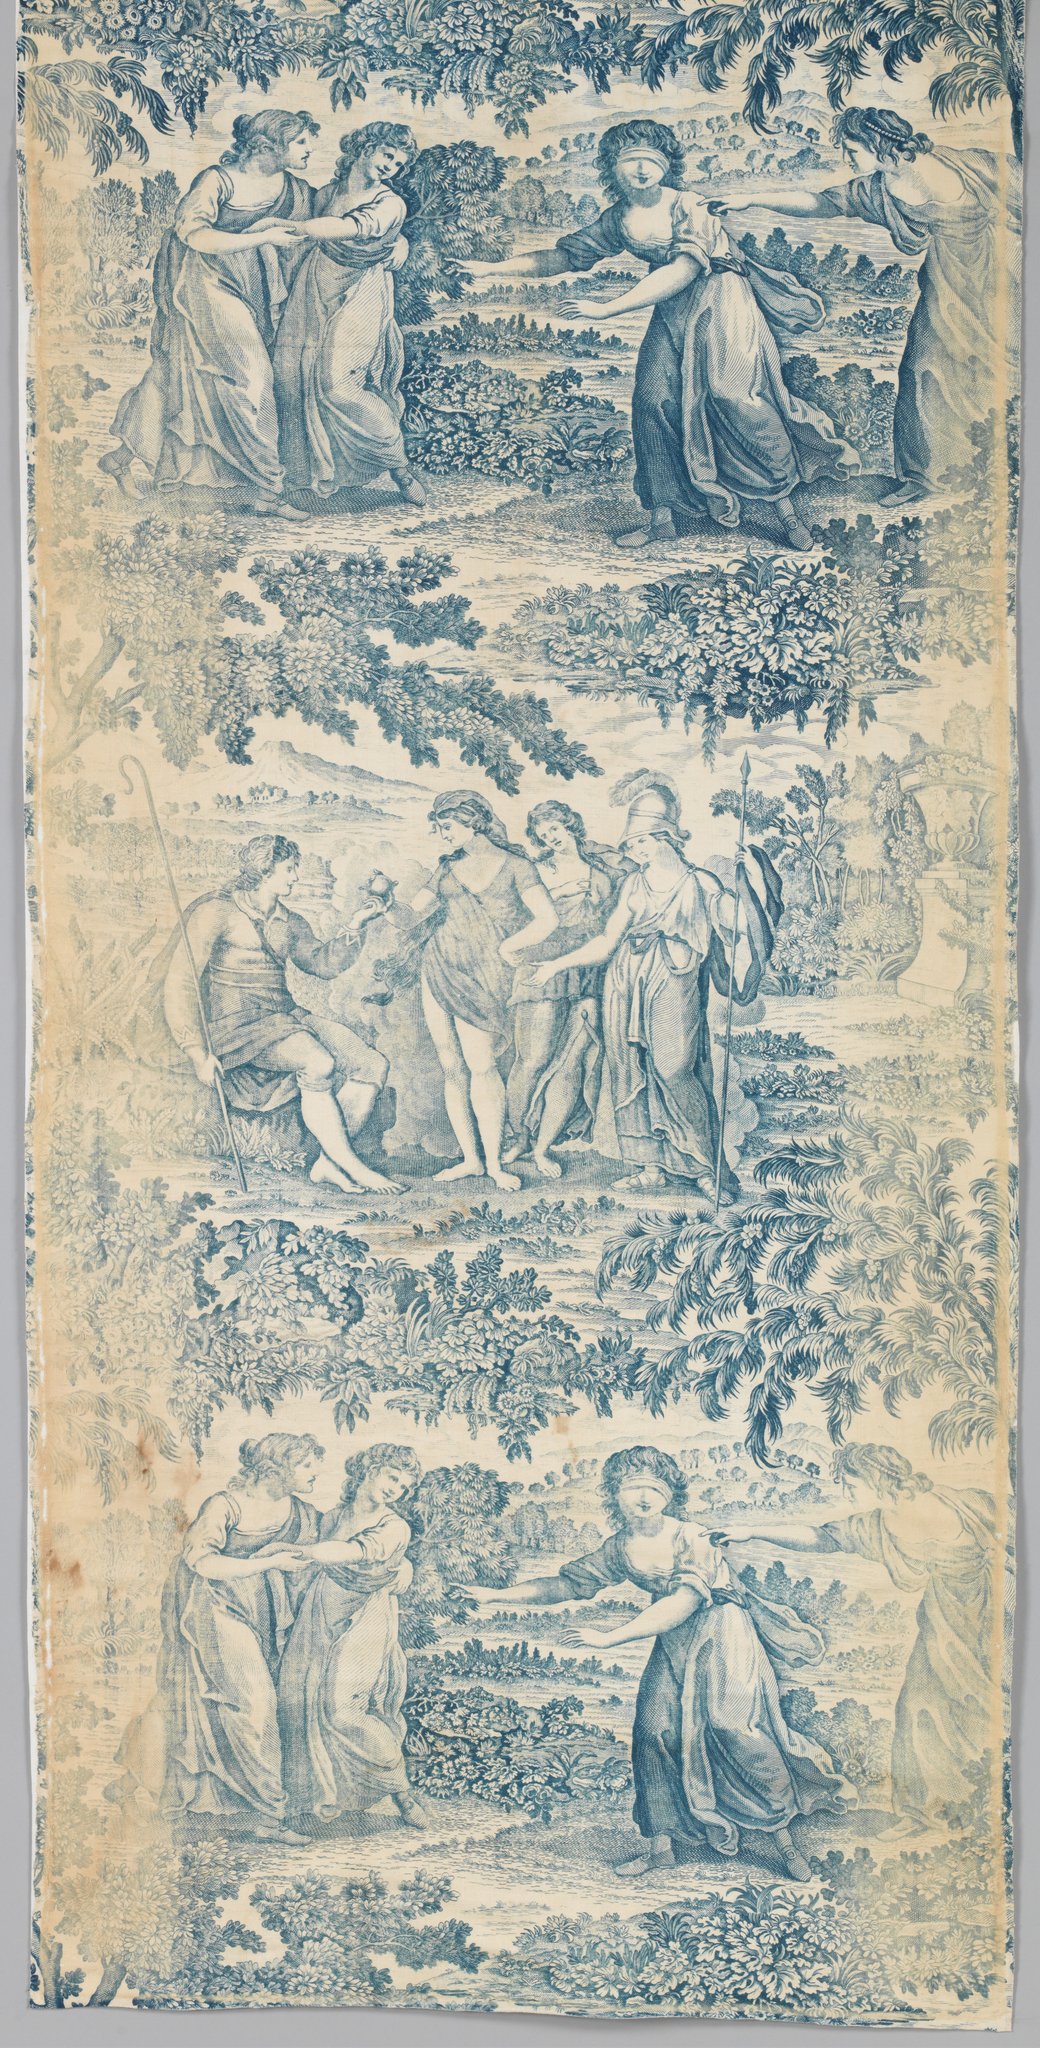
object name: piece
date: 1800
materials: cotton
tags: men,women,playing,trees